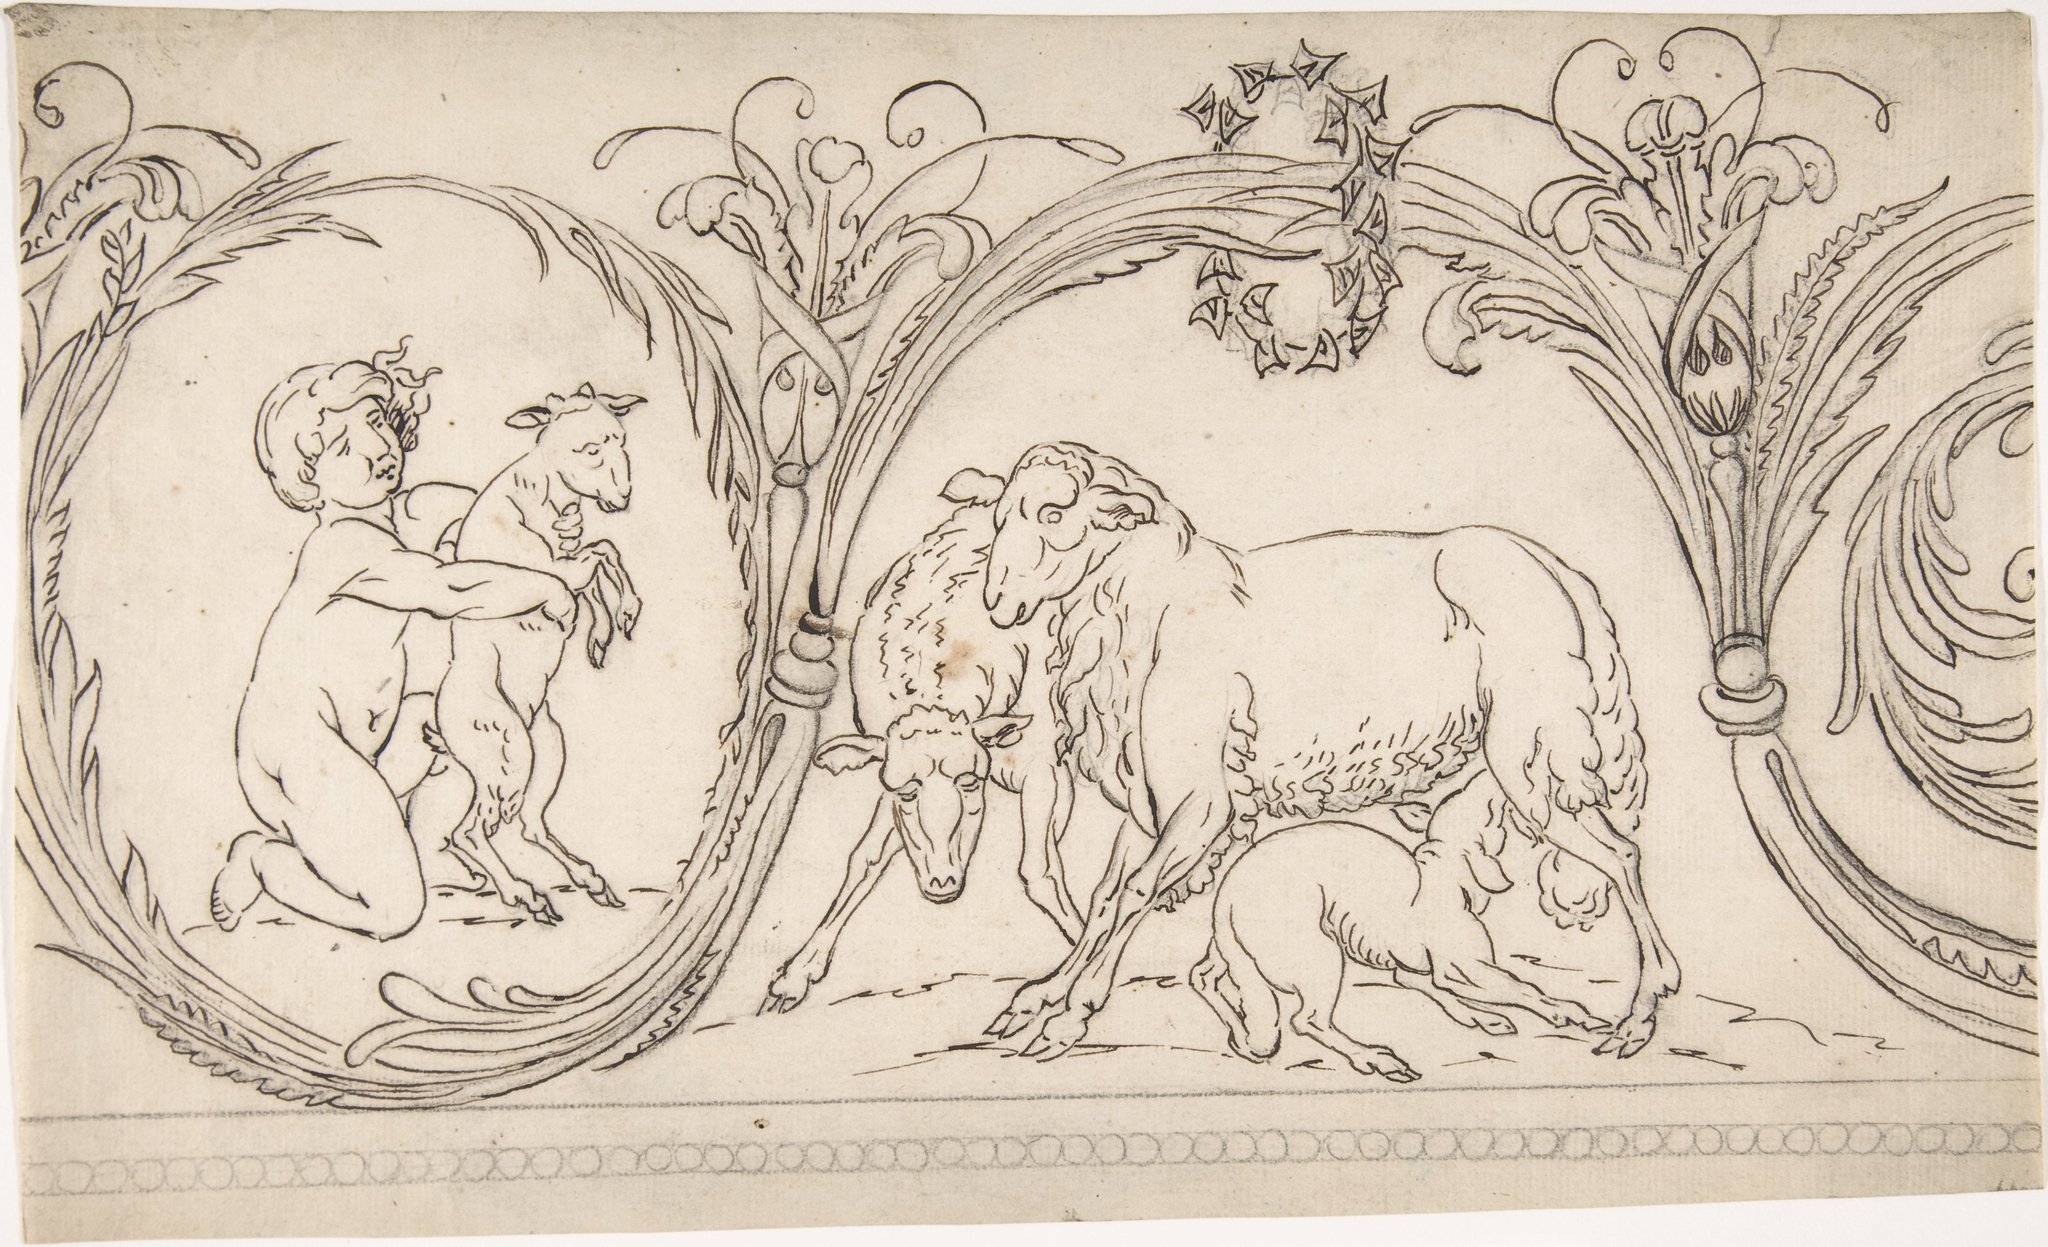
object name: drawing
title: Ornament Containing a Boy and some Sheep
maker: anonymous, german, 19th century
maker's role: artist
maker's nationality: german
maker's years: 1800-1899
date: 1780-1820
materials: crayon, graphite, ink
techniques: pen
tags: ornament,boys,sheep